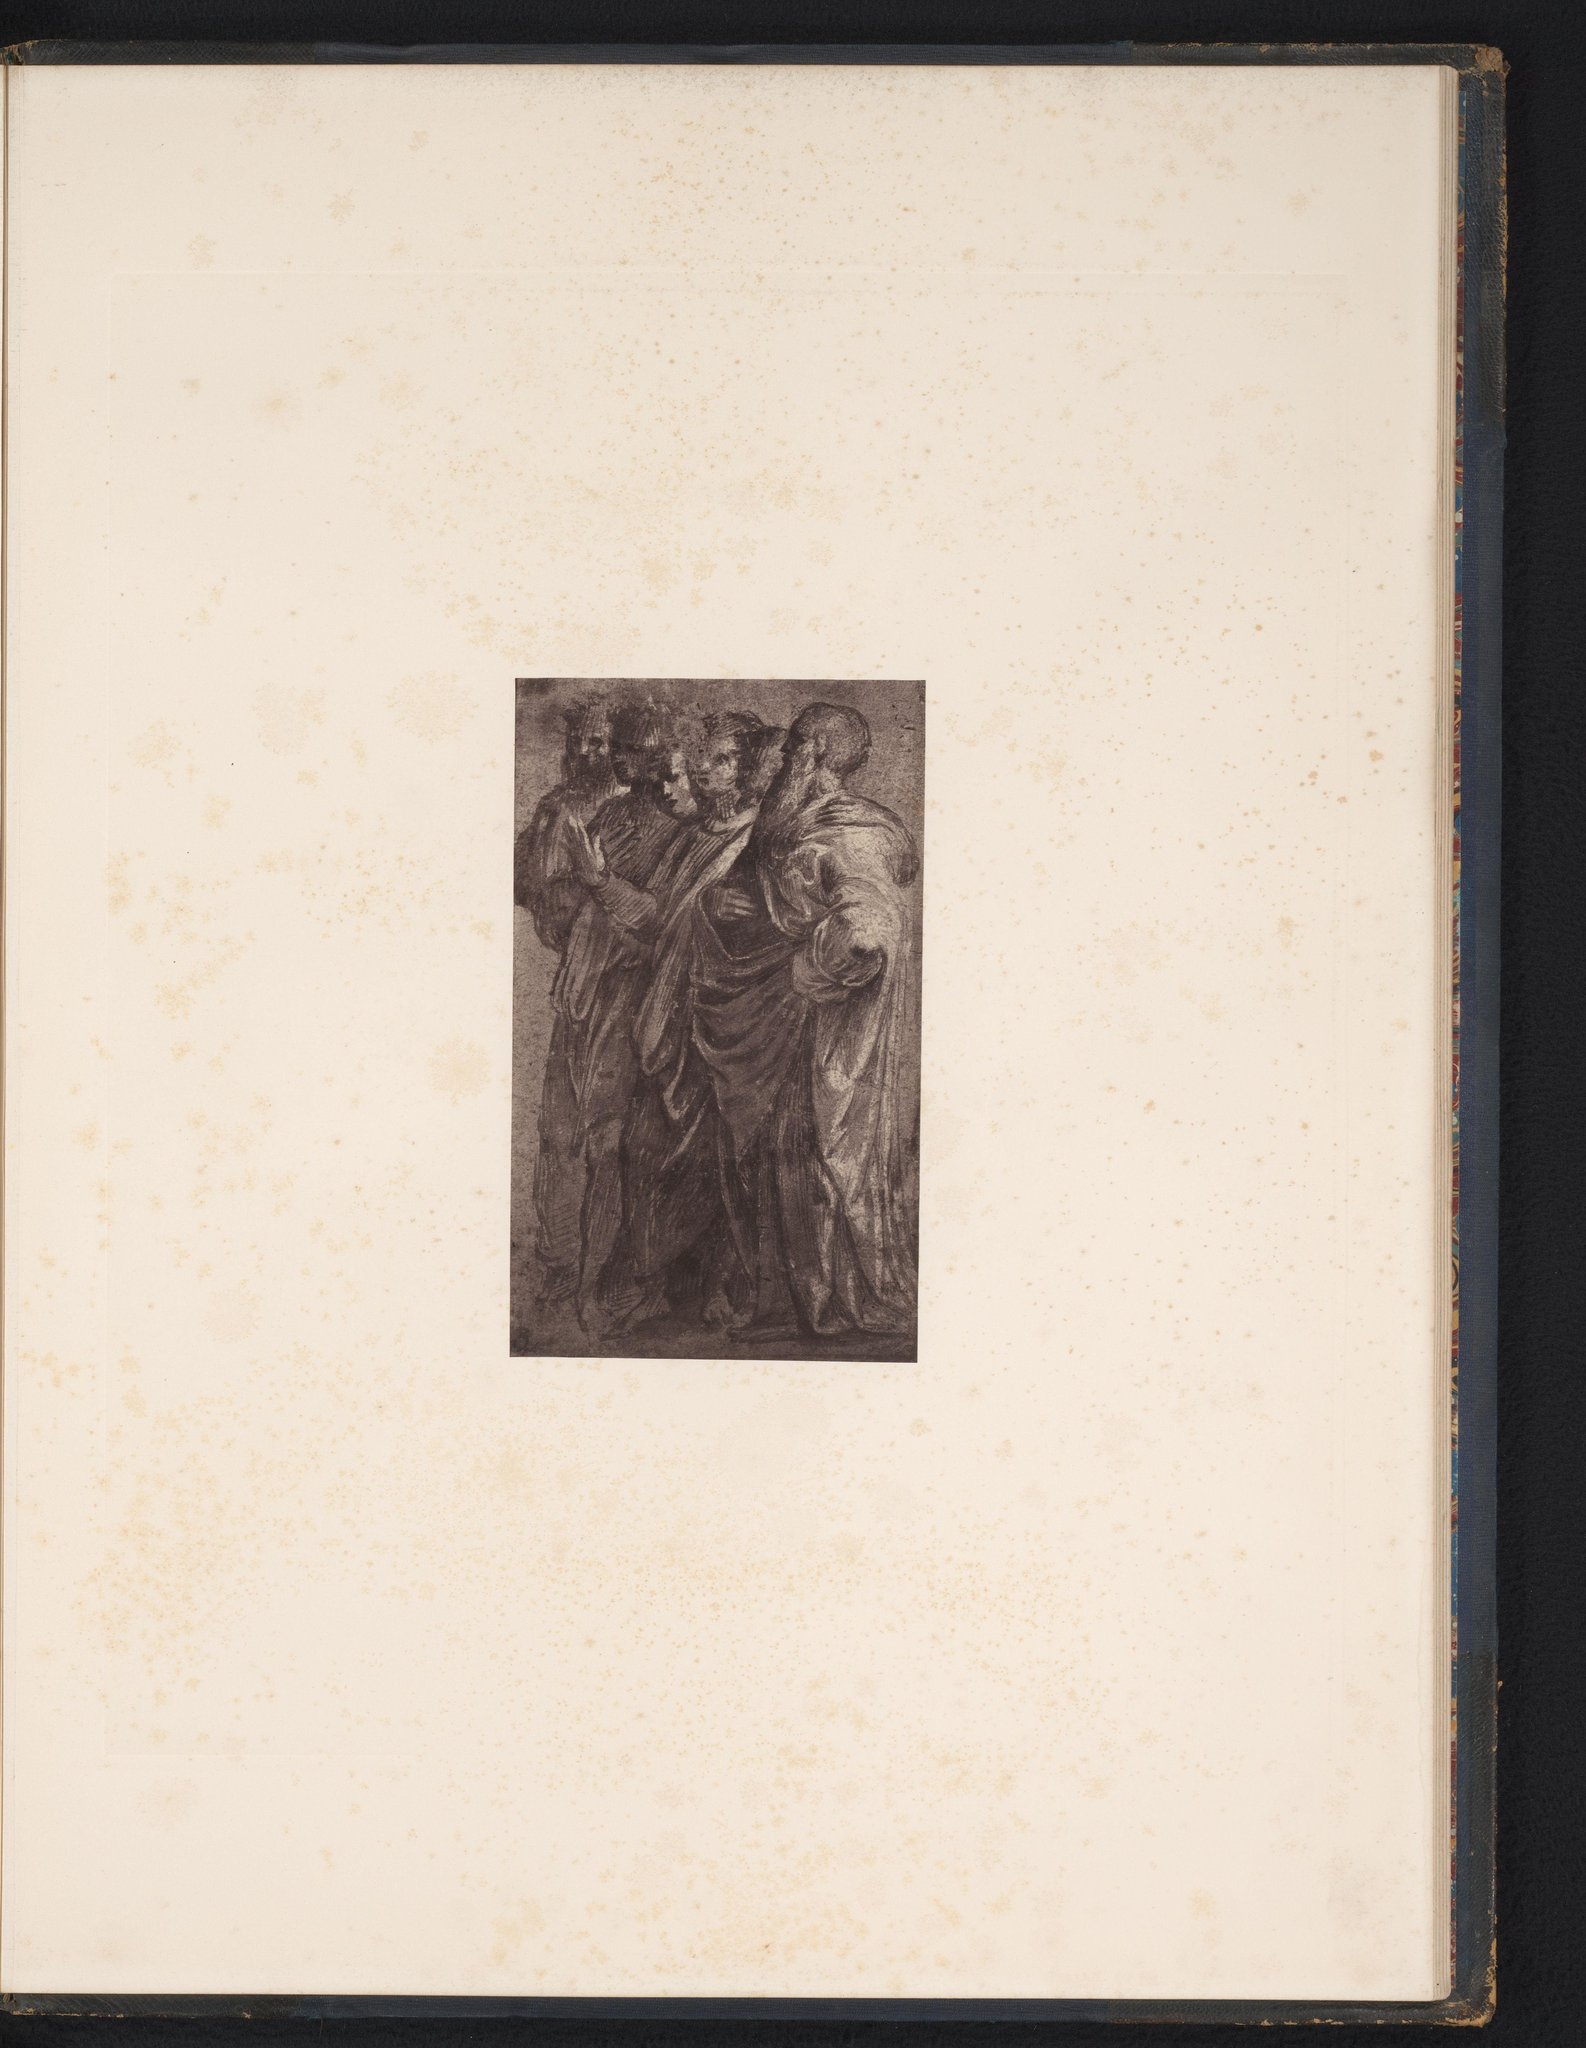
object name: photograph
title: Fotoreproductie van een tekening van Rafaël, zes wijzen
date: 1852-1857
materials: paper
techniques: albumen print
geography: windsor castle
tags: wise man